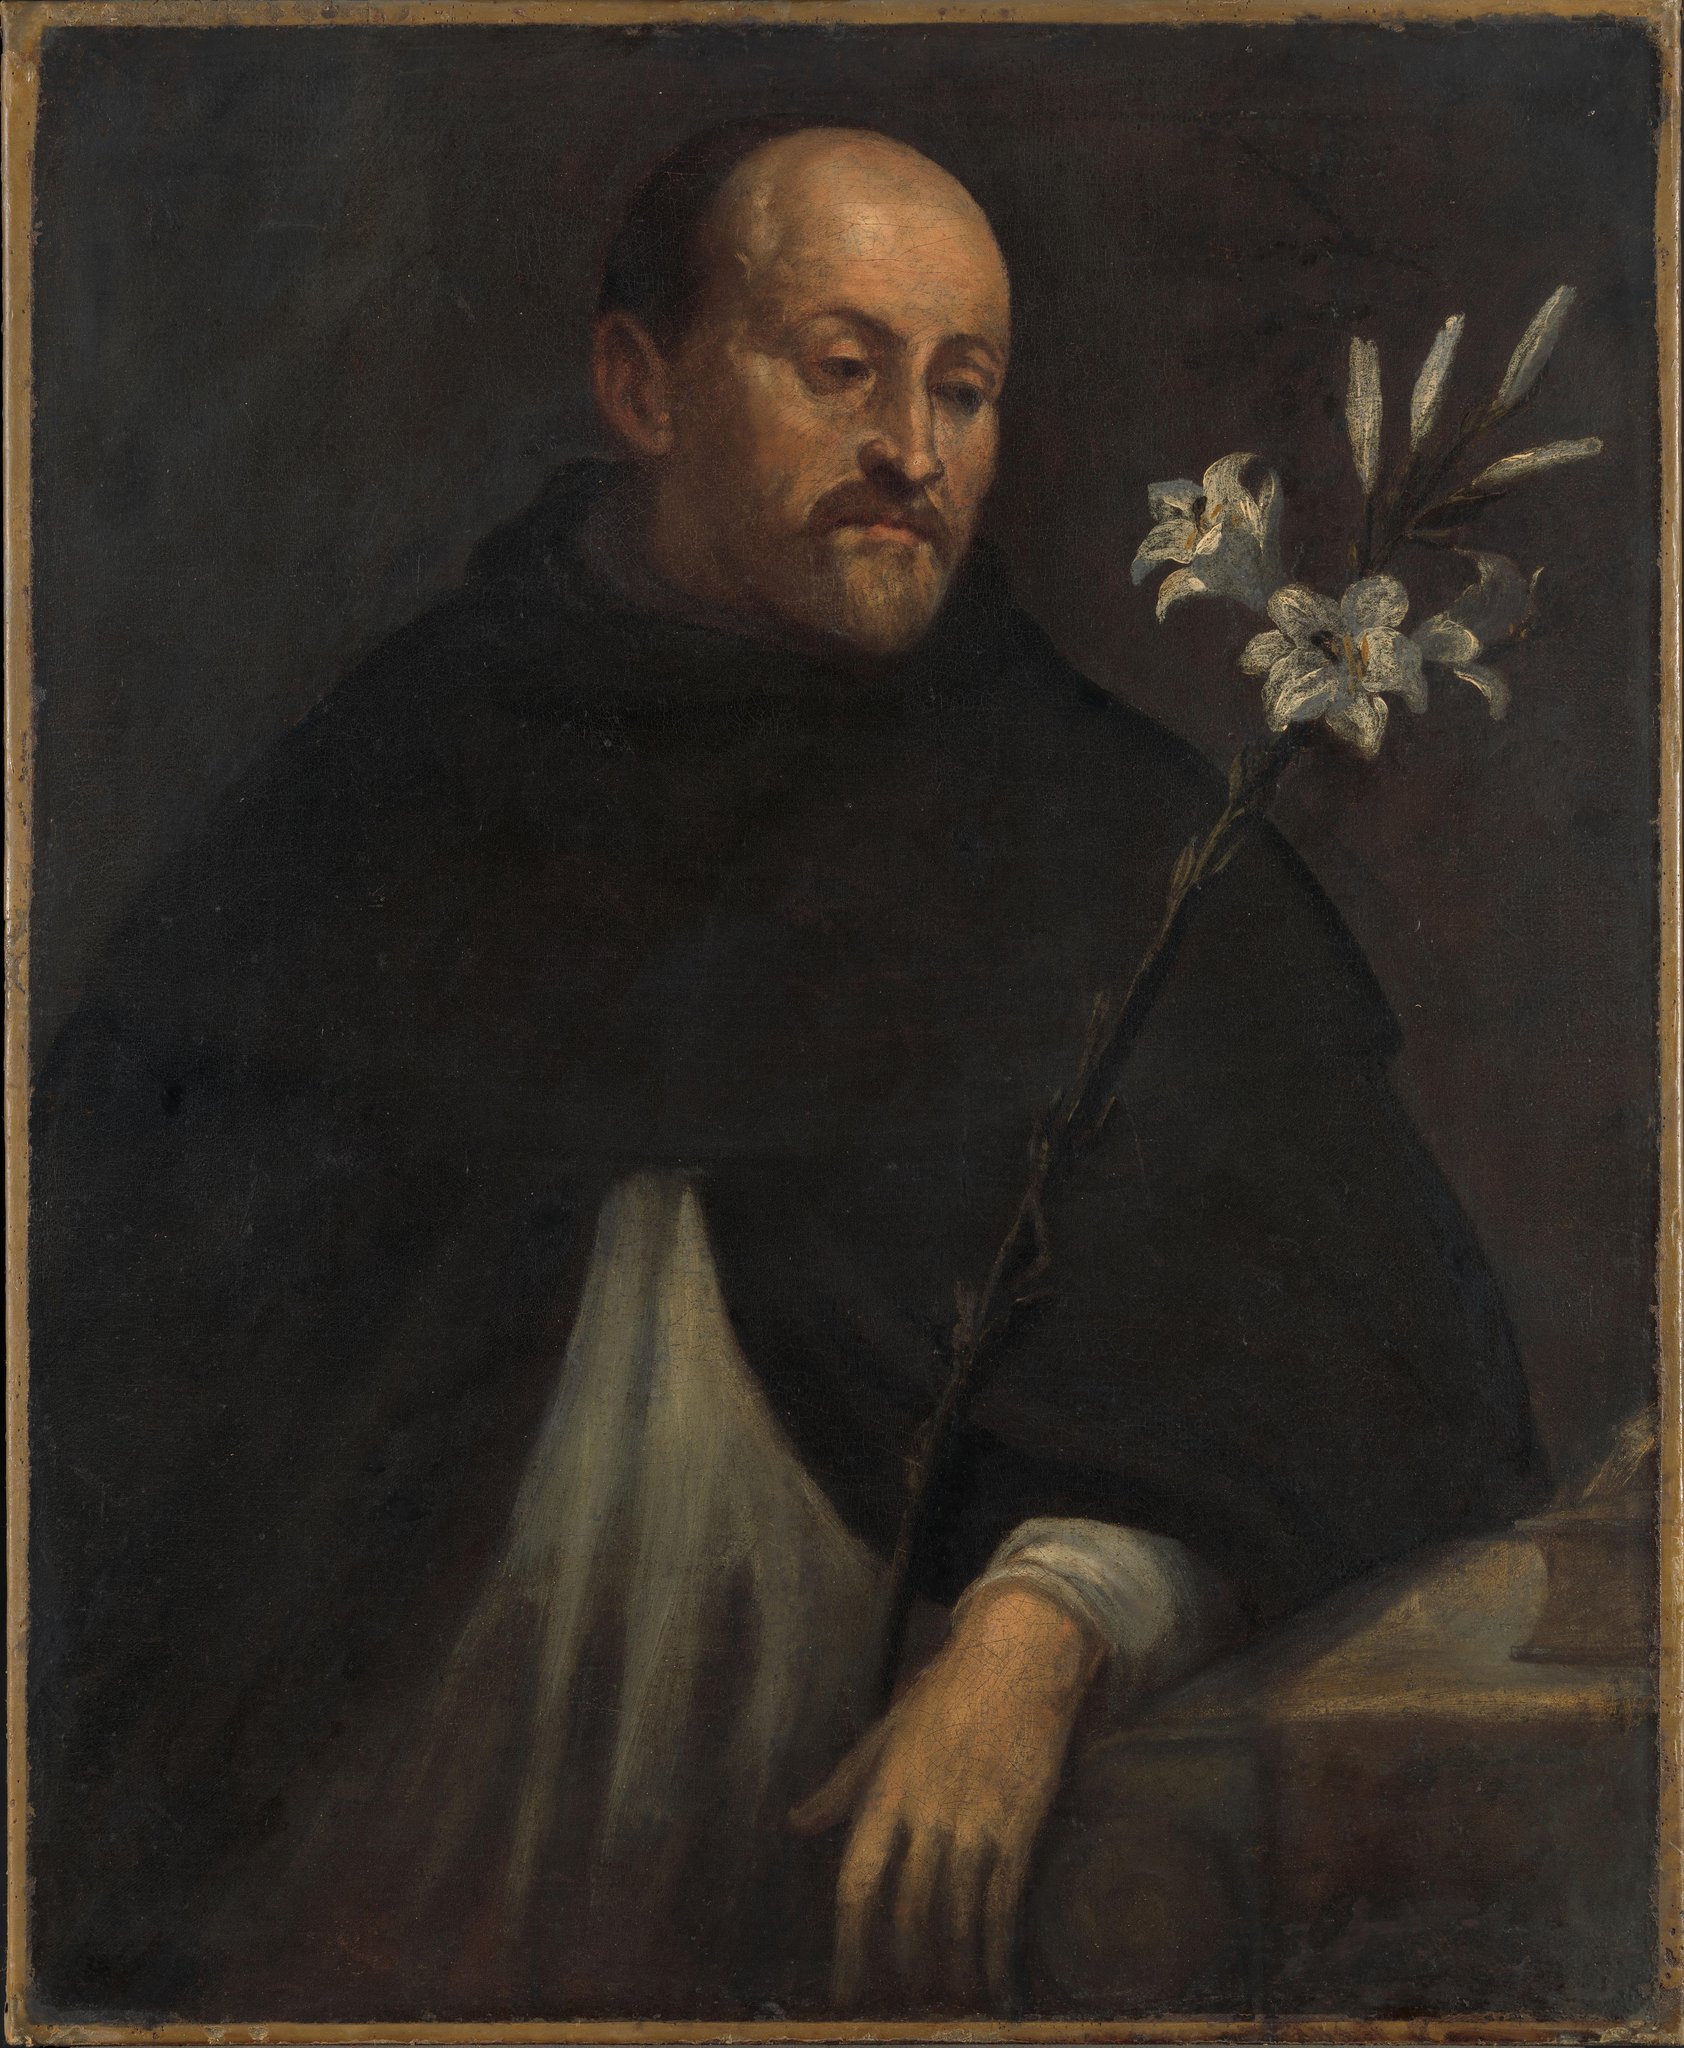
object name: painting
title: Saint Dominic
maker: Anonymous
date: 1550-1600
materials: canvas, oil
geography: venice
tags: dominic(us) guzman of calerueja, founder of the order of preachers (or dominican (black) friars; possible attributes: book, dog with flaming torch, lily, loaf of bread, rosary, star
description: De heilige Dominicus, halffiguur zittend met een lelietak in de hand.